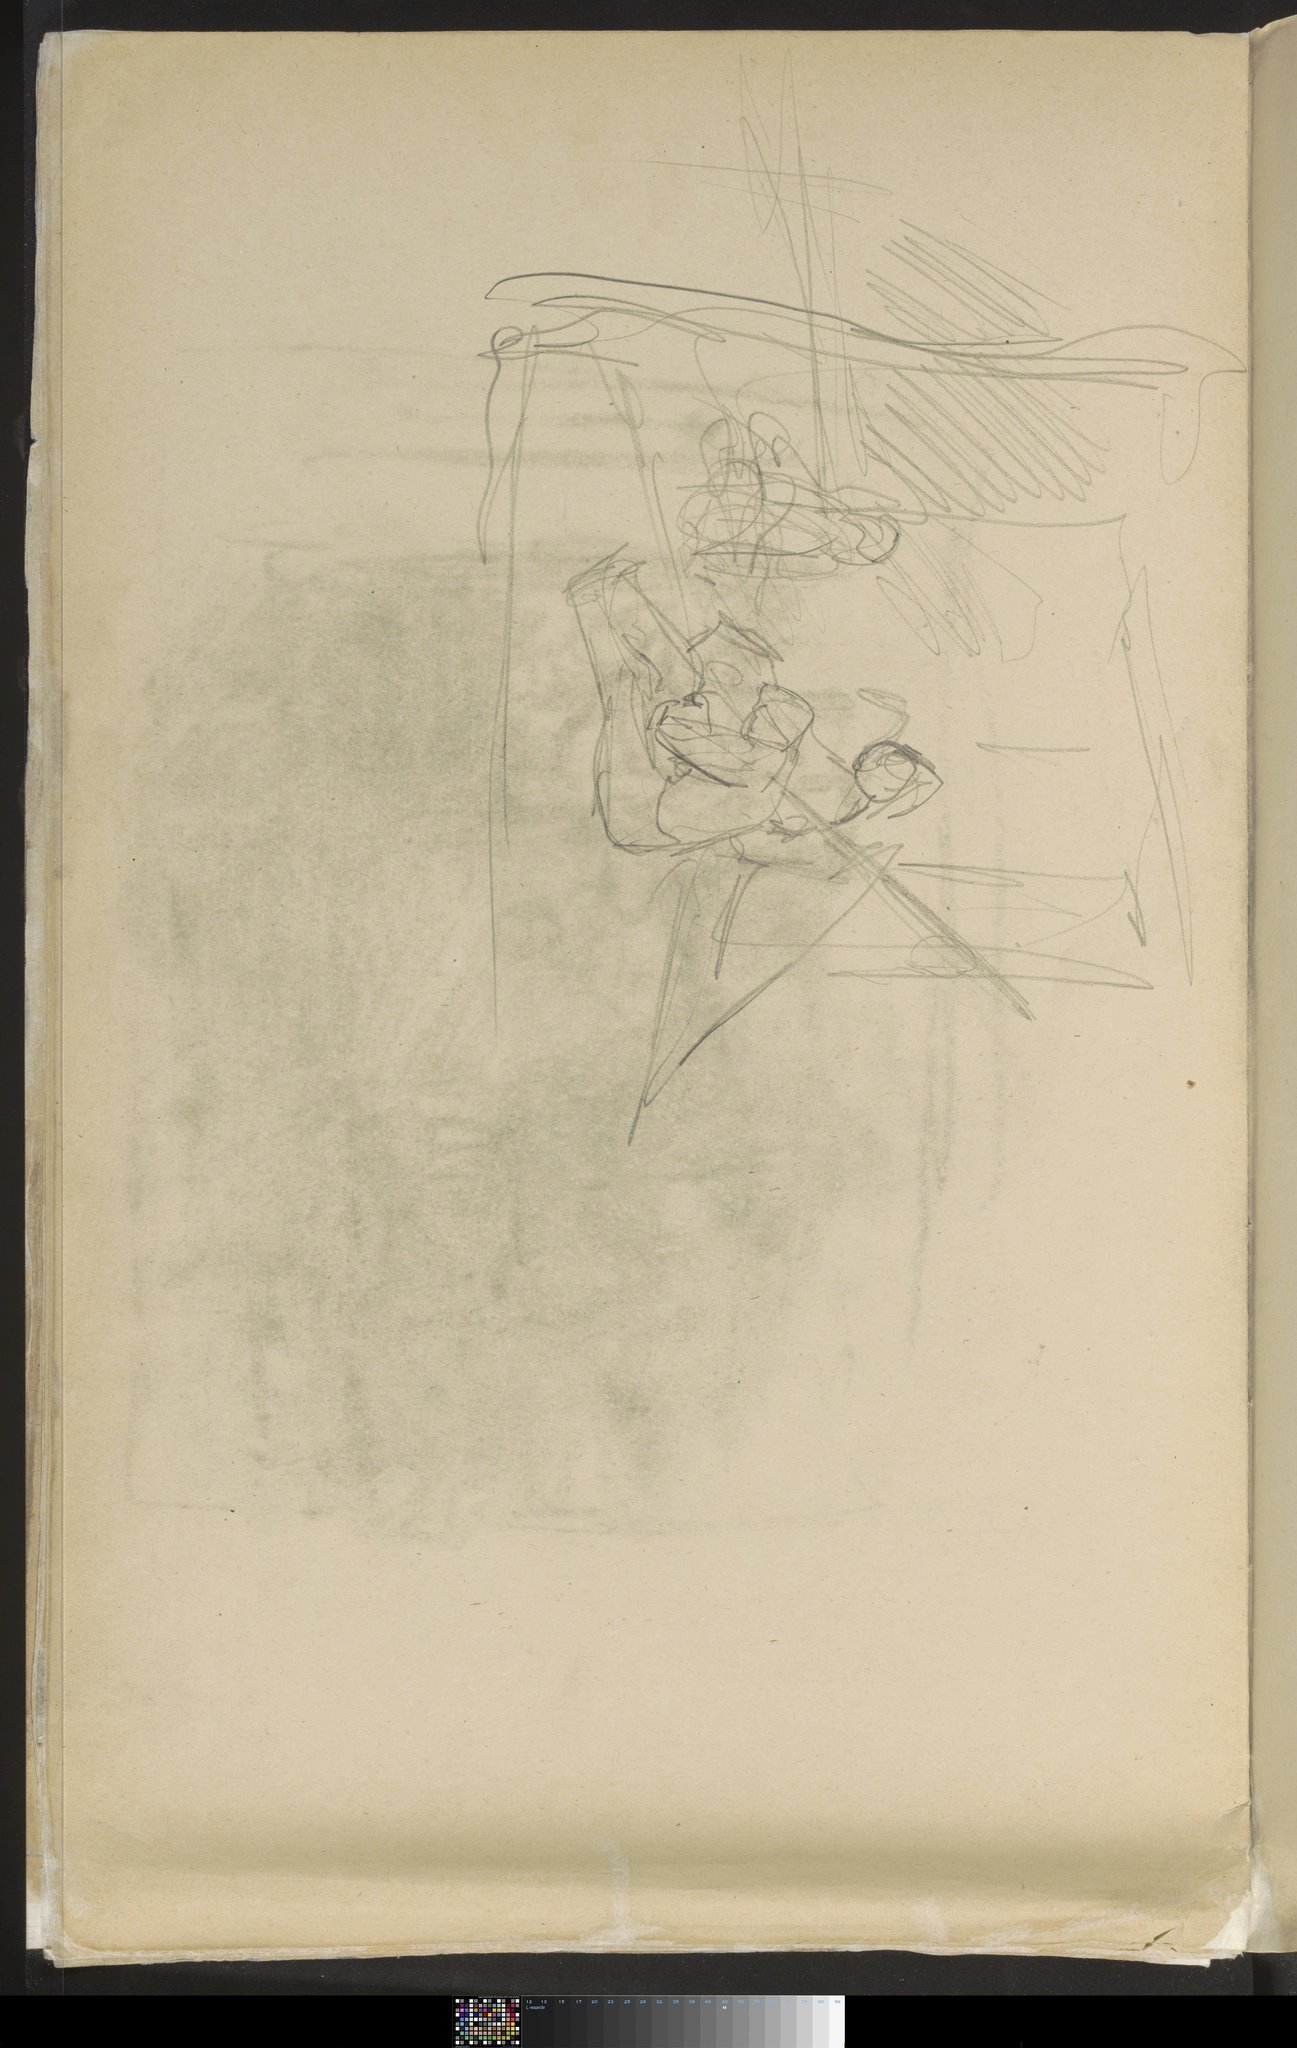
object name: sketchbook leaf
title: Interieur met drie figuren die op de vloer zitten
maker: albert neuhuys (1844-1914)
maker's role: draughtsman, painter, print maker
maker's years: 1844-1914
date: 1854-1914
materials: paper, pencil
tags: sitting figure, interior of the house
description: Blad 10 verso uit een schetsboek met 53 bladen.